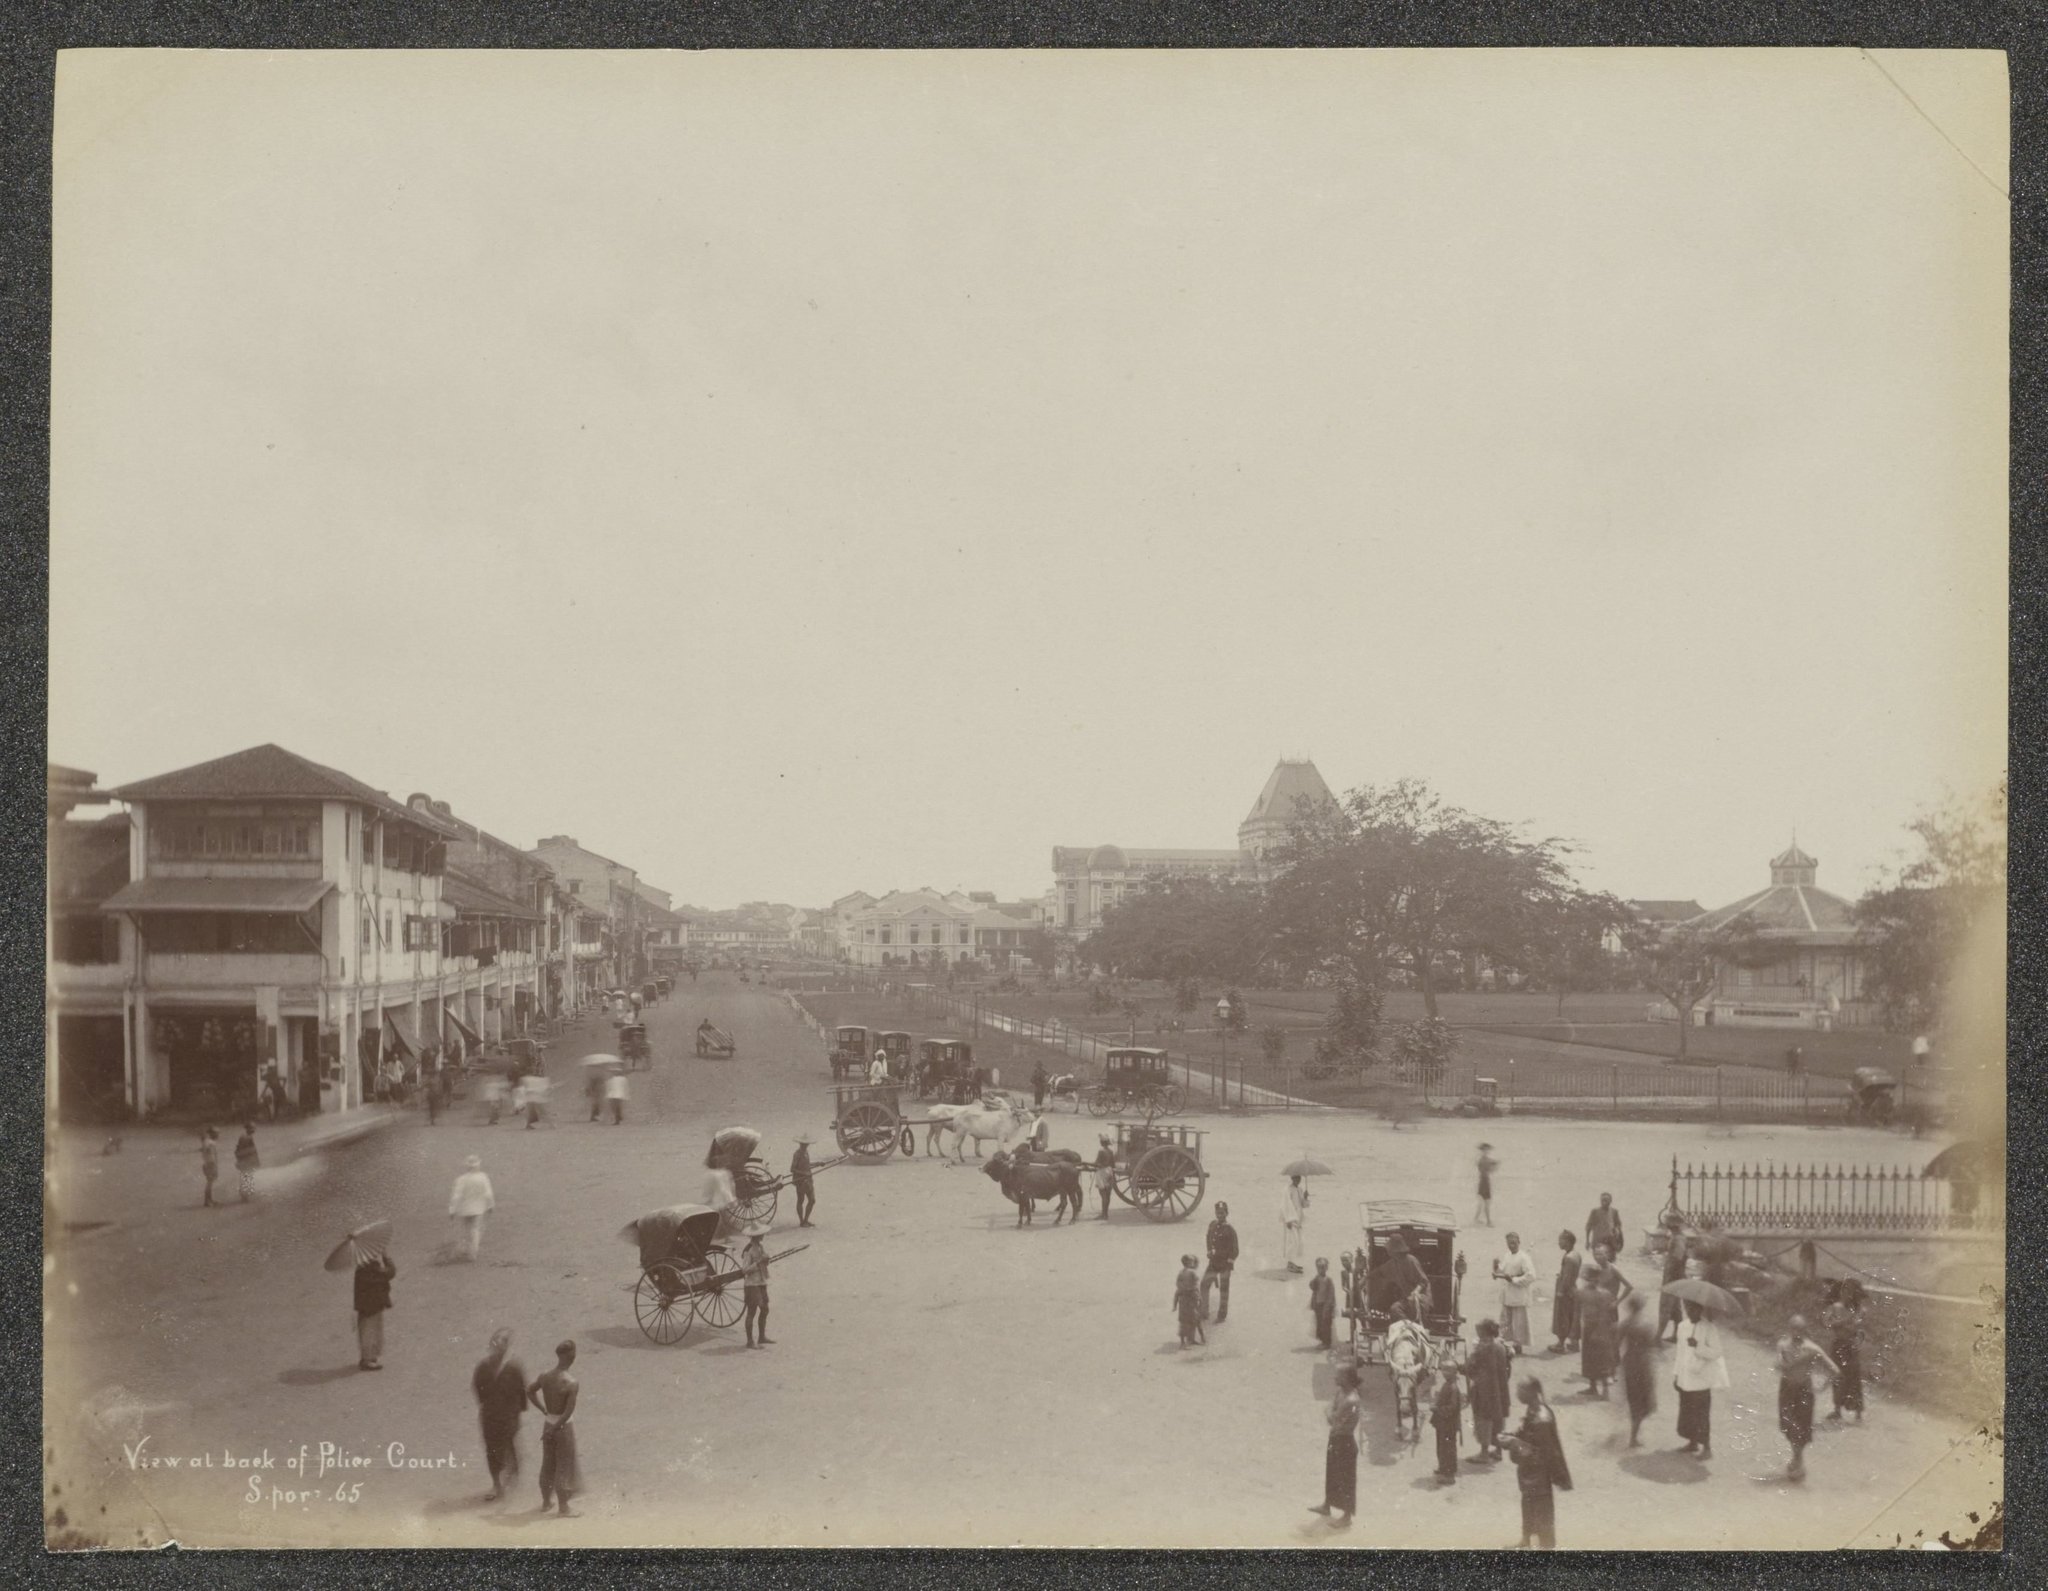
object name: album leaf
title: Gezicht op een plein achter een gerechtsgebouw in Singapore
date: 1870-1900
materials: paper, photographic support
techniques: albumen print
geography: singapore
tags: square, place, circus, etc. (+ city(-scape) with figures, staffage), singapore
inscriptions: negative number: ‘65’, check stamp: ‘G.R. Lambert Singapore’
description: Onderdeel van Album met 50 foto's van een reis door Zuidoost-Azië.